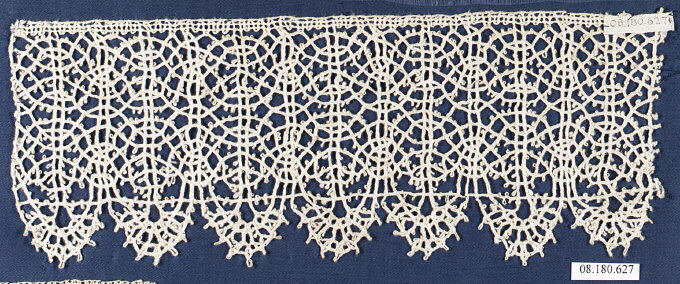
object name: piece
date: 1801-1900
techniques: lace